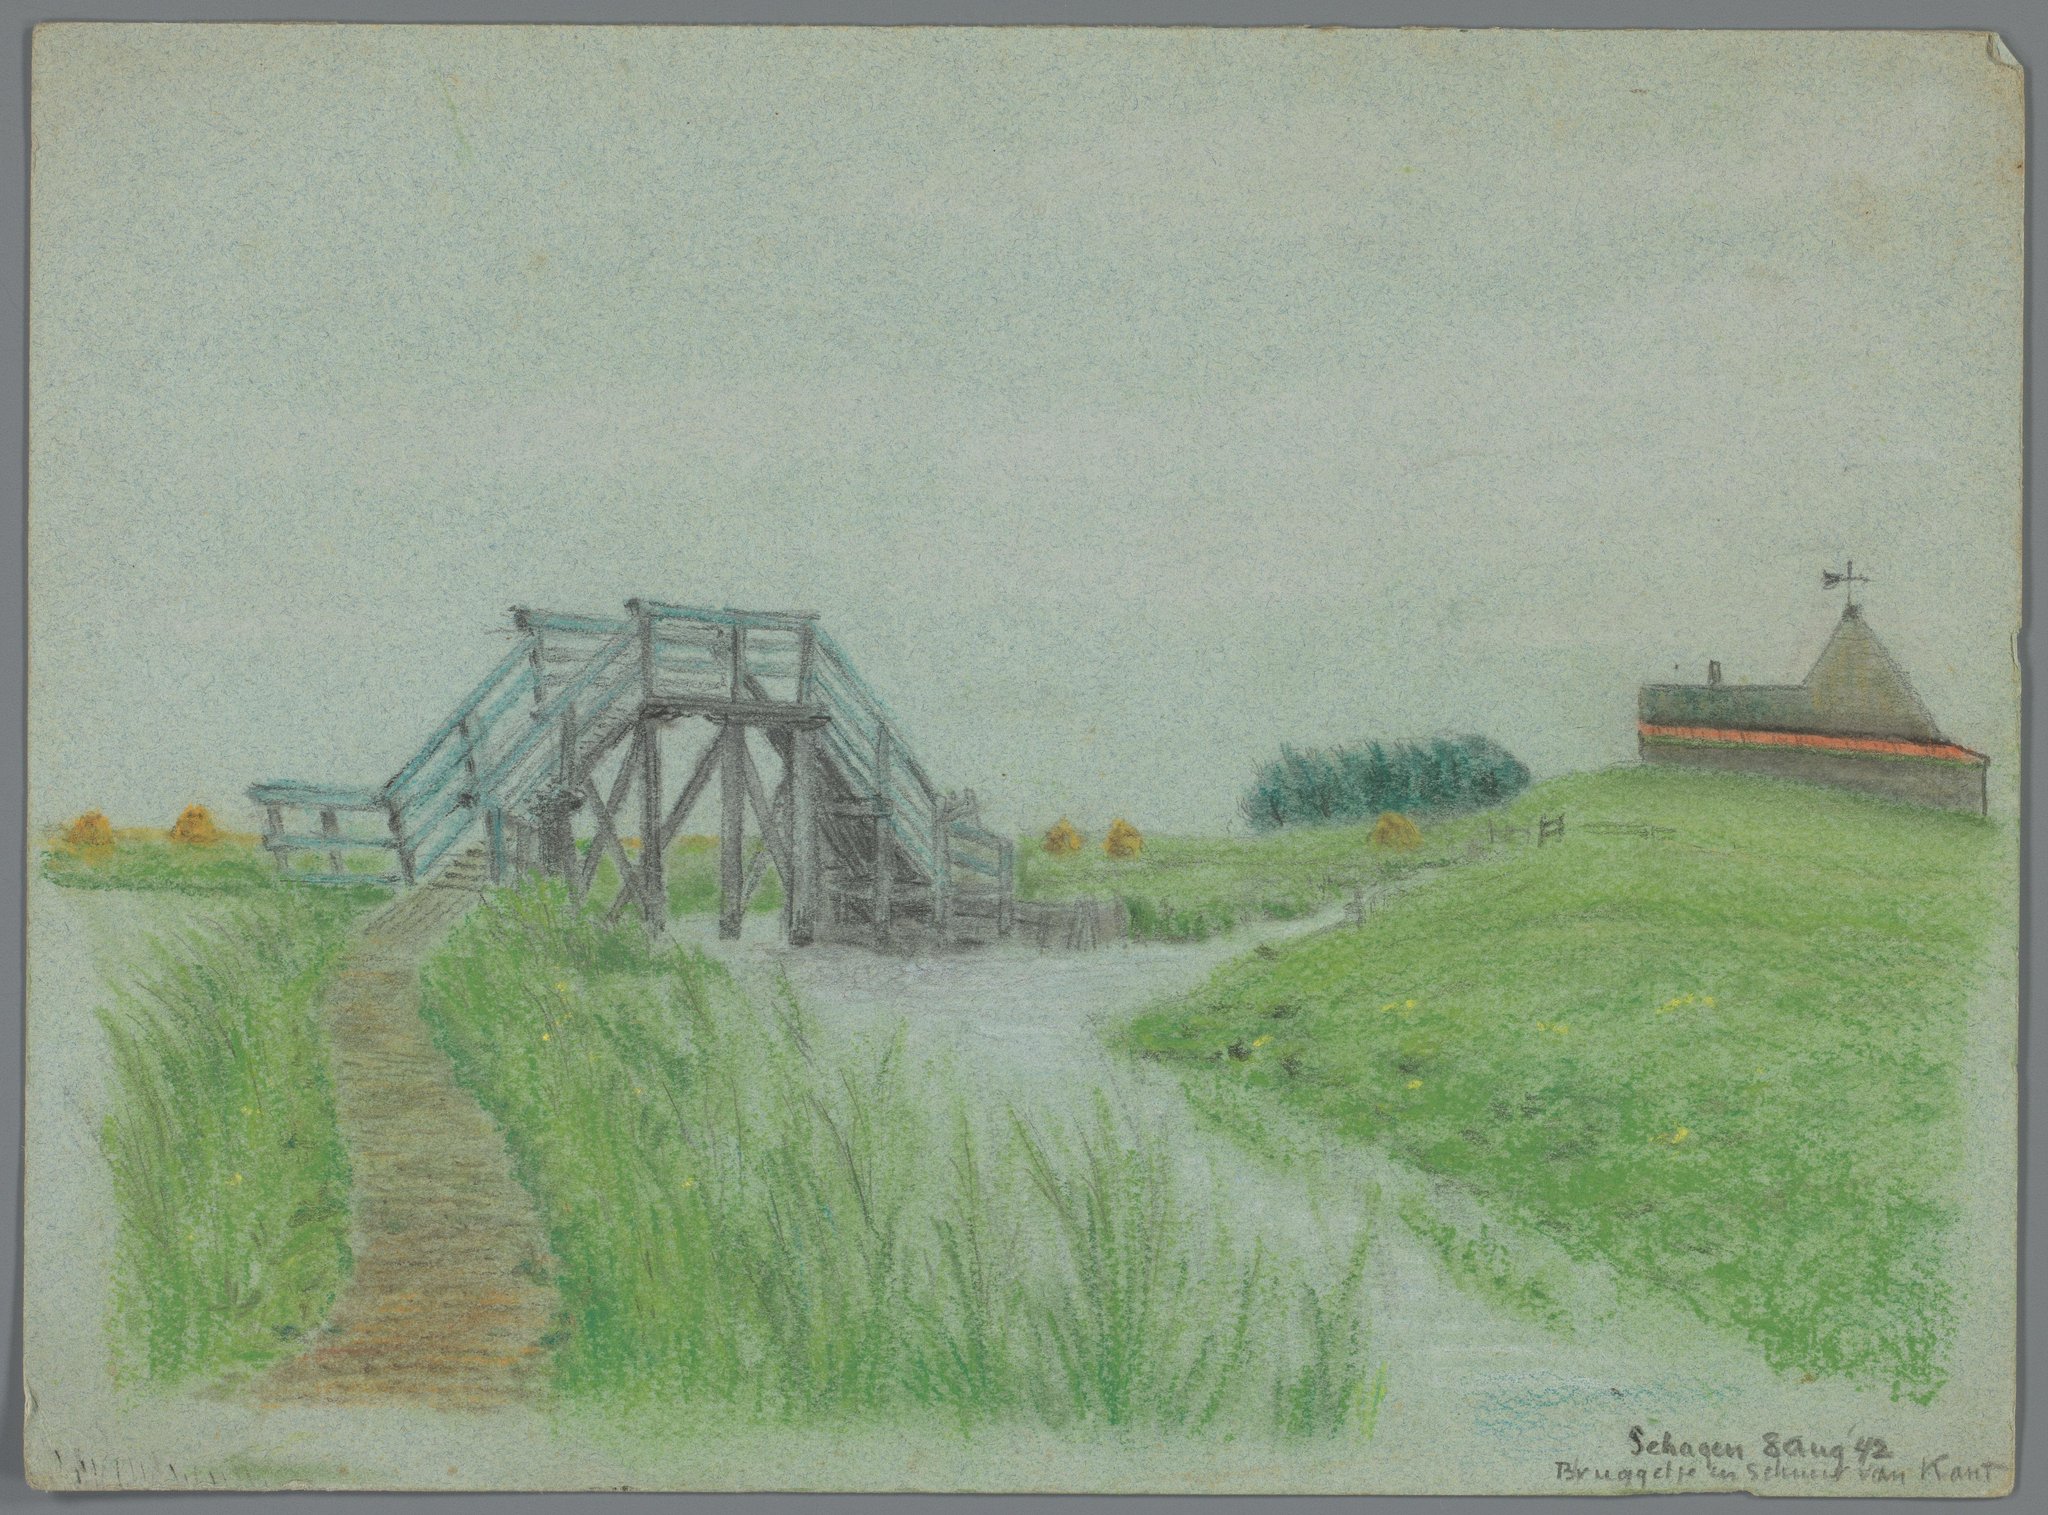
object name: drawing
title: Gezicht op een landschap met brug en schuur te Schagen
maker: jacob olie jr.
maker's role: fotograaf, scheikundige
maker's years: 1879-1955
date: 1942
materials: chalk, pastel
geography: schagen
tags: barn, bridge, schagen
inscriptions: annotation: ‘Schagen 8 aug '42/ Bruggetje en schuur van Kant’